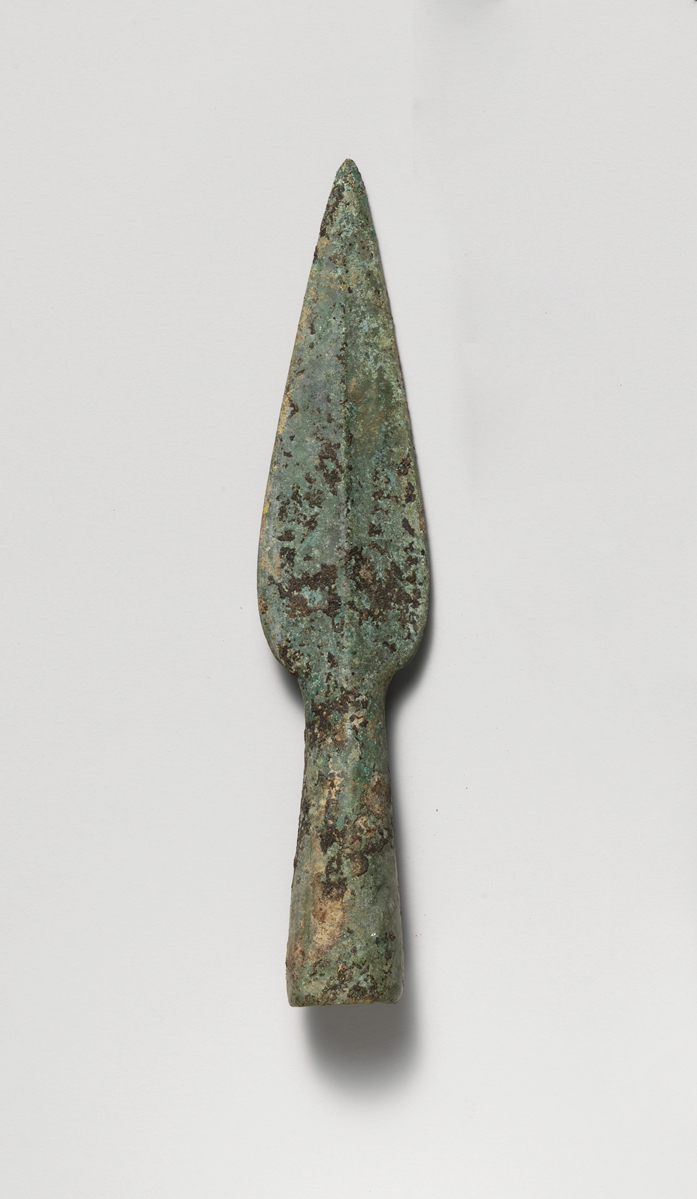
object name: spear point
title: Miniature bronze spearhead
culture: etruscan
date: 500-401 BCE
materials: bronze